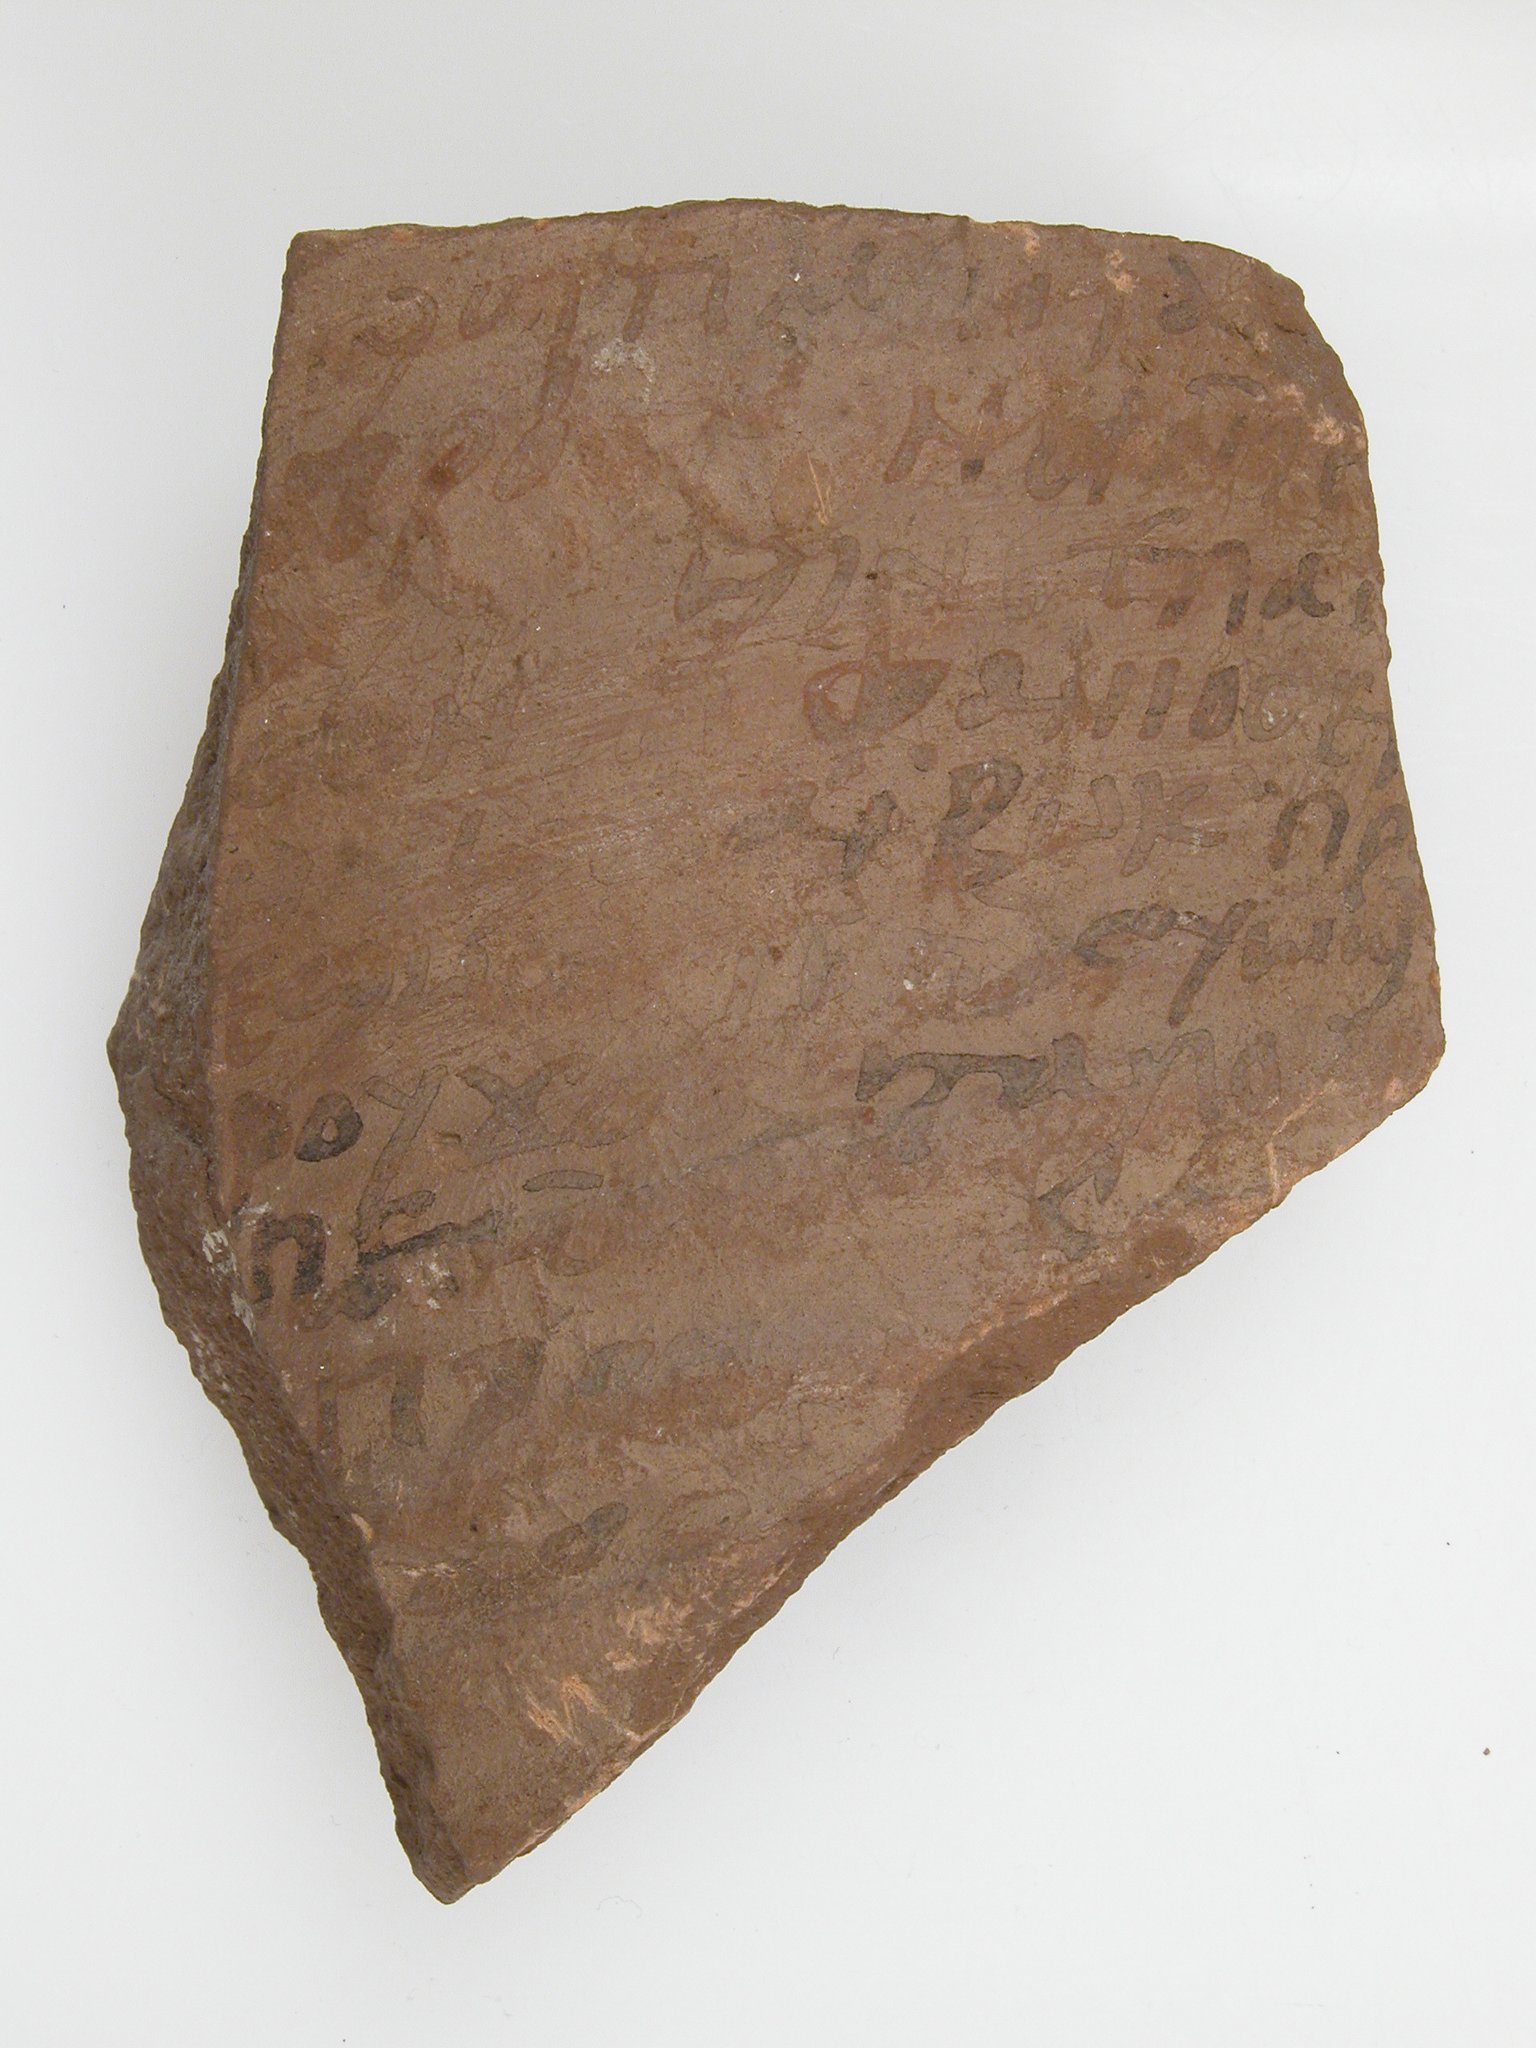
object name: ostrakon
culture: coptic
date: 601-700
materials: ink, pottery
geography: egypt